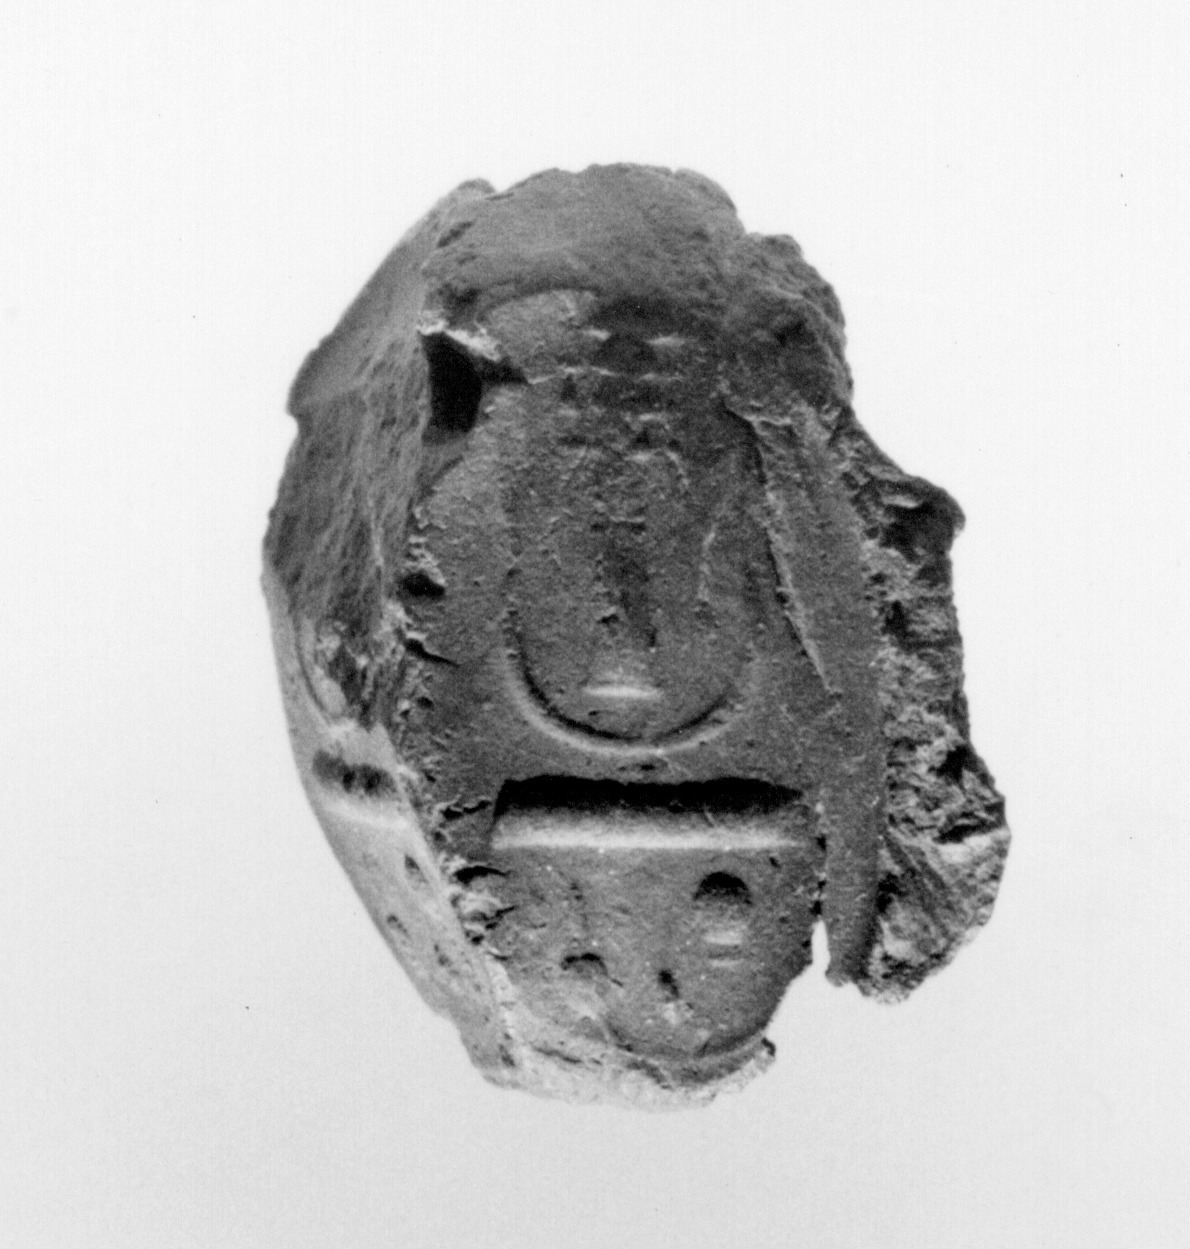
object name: sealing, djed, ka arm,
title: Document Sealing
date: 1390-1352 BCE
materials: mud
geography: egypt